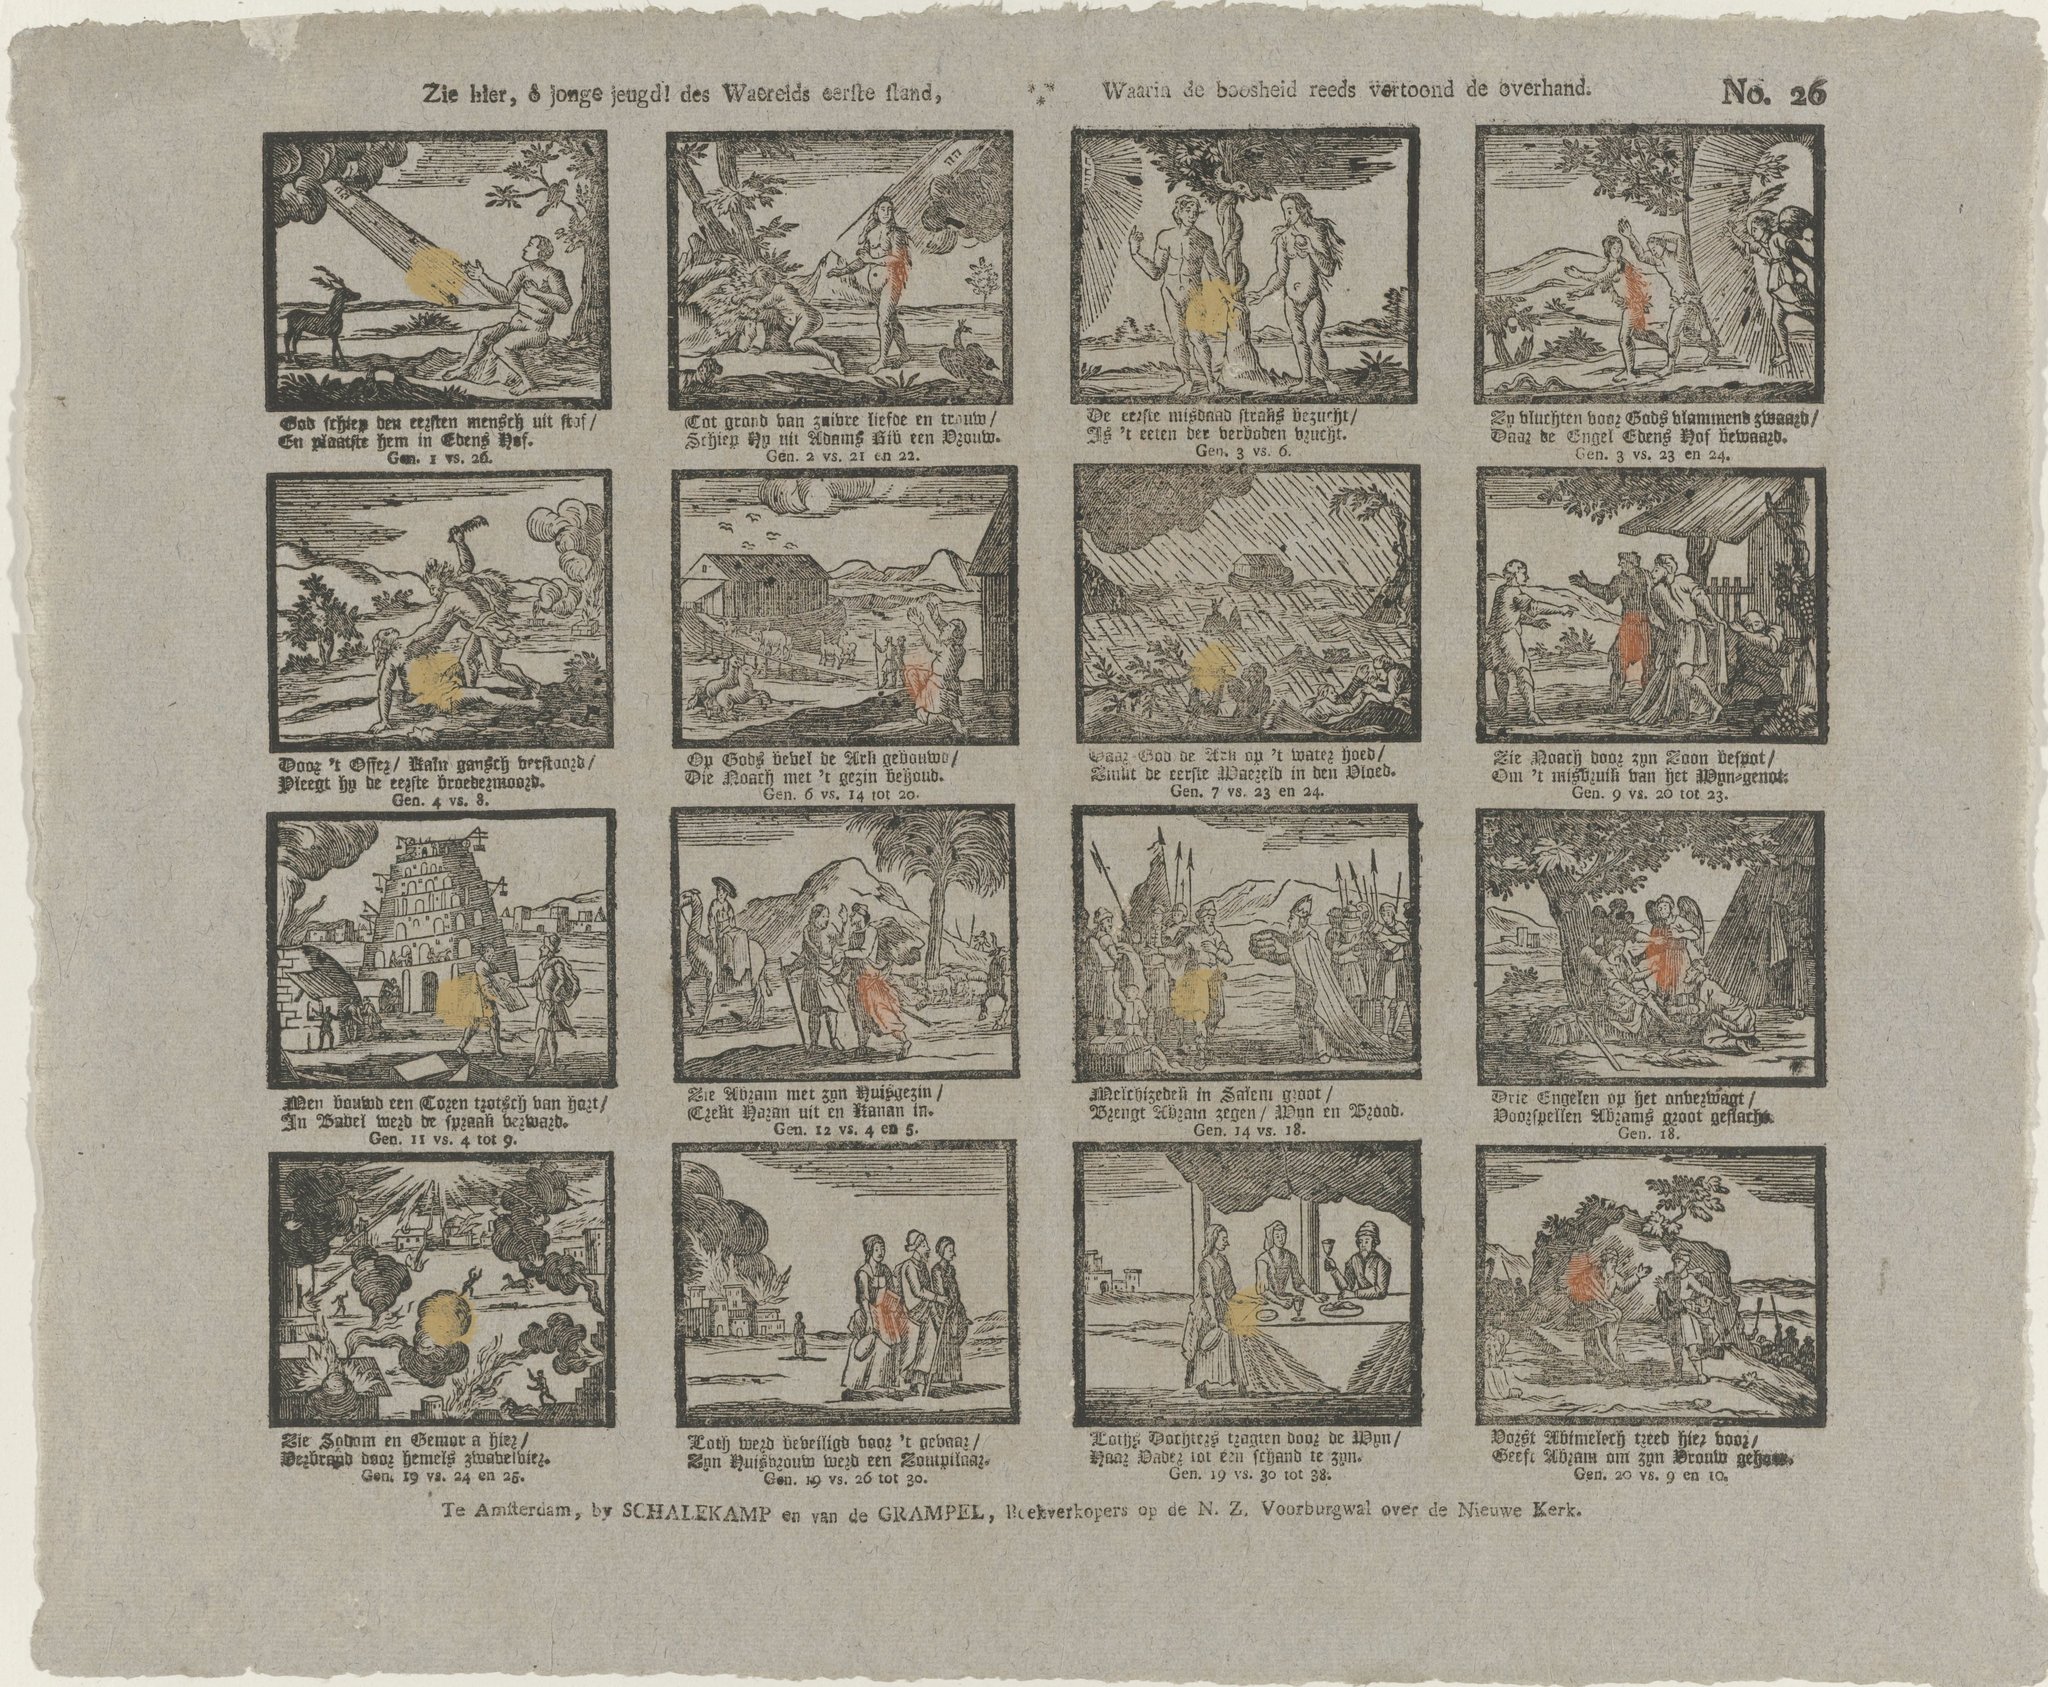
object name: print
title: Zie hier, ô jonge jeugd! des Waerelds eerste stand, / Waarin de boosheid reeds vertoond de overhand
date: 1795-1819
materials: paper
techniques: colour, letterpress printing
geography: amsterdam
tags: abel's death, adam and eve in paradise (before the fall), lot and his daughters (genesis 19:30-38), the tower of babel, expulsion of adam and eve from paradise (genesis 3:22-24), story of noah, old testament, temptation and fall: adam and eve in paradise (after the fall) (genesis 3:8-21)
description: Blad met 16 voorstellingen van verhalen uit het Oude Testament, zoals de dood van Abel en het vertrek van Lot met zijn familie uit Sodom. Onder elke afbeelding een tweeregelig vers en een verwijzing naar de bijbehorende Bijbeltekst. Genummerd rechtsboven: No. 26.